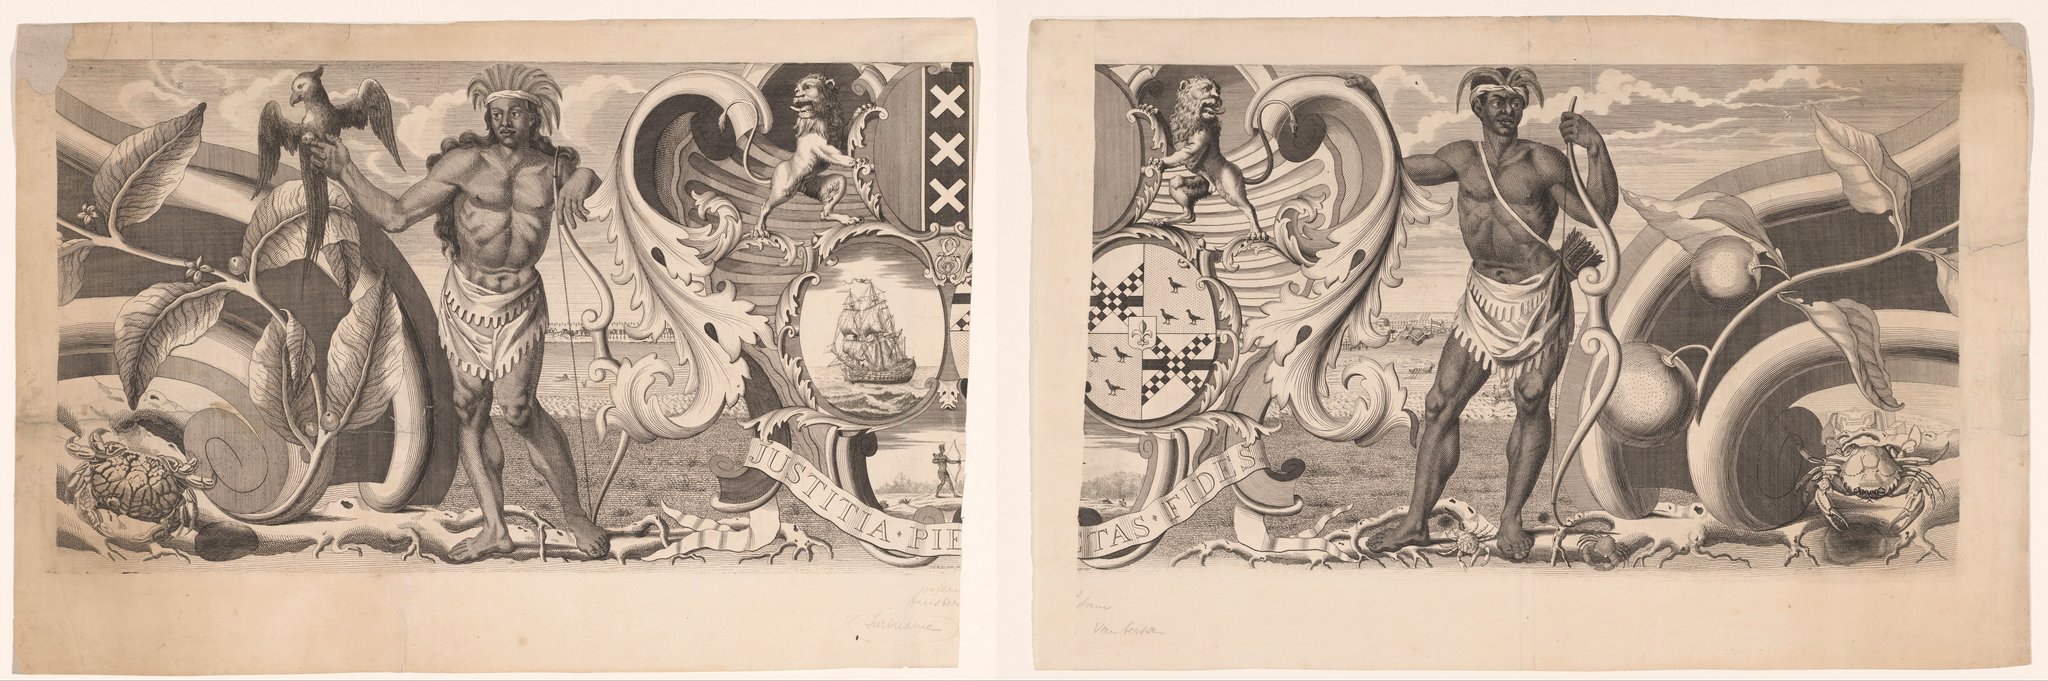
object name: print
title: Deel van de rand van een kaart van Suriname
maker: j.g. de la croix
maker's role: painter, print maker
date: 1737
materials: paper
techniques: engraving, etching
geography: netherlands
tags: coat of arms (as symbol of the state, etc.), sailing-ship, sailing-boat, indigenous peoples of south america, slavery; serfs and enslaved persons, crustaceans: crab, americans with african roots, african-americans, ornament derived from plant forms, armorial bearing, heraldry, suriname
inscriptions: collector's mark: Lugt 2228, inscription: ‘s d.’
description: Onderdeel van de rand van een kaart van Suriname (zie inv.nr. NG-539). De kaart werd gemaakt in opdracht van de Sociëteit van Suriname, het bestuur van de kolonie. Dit object is omwille van een betere presentatie virtueel samengevoegd maar bestaat fysiek uit losse onderdelen.